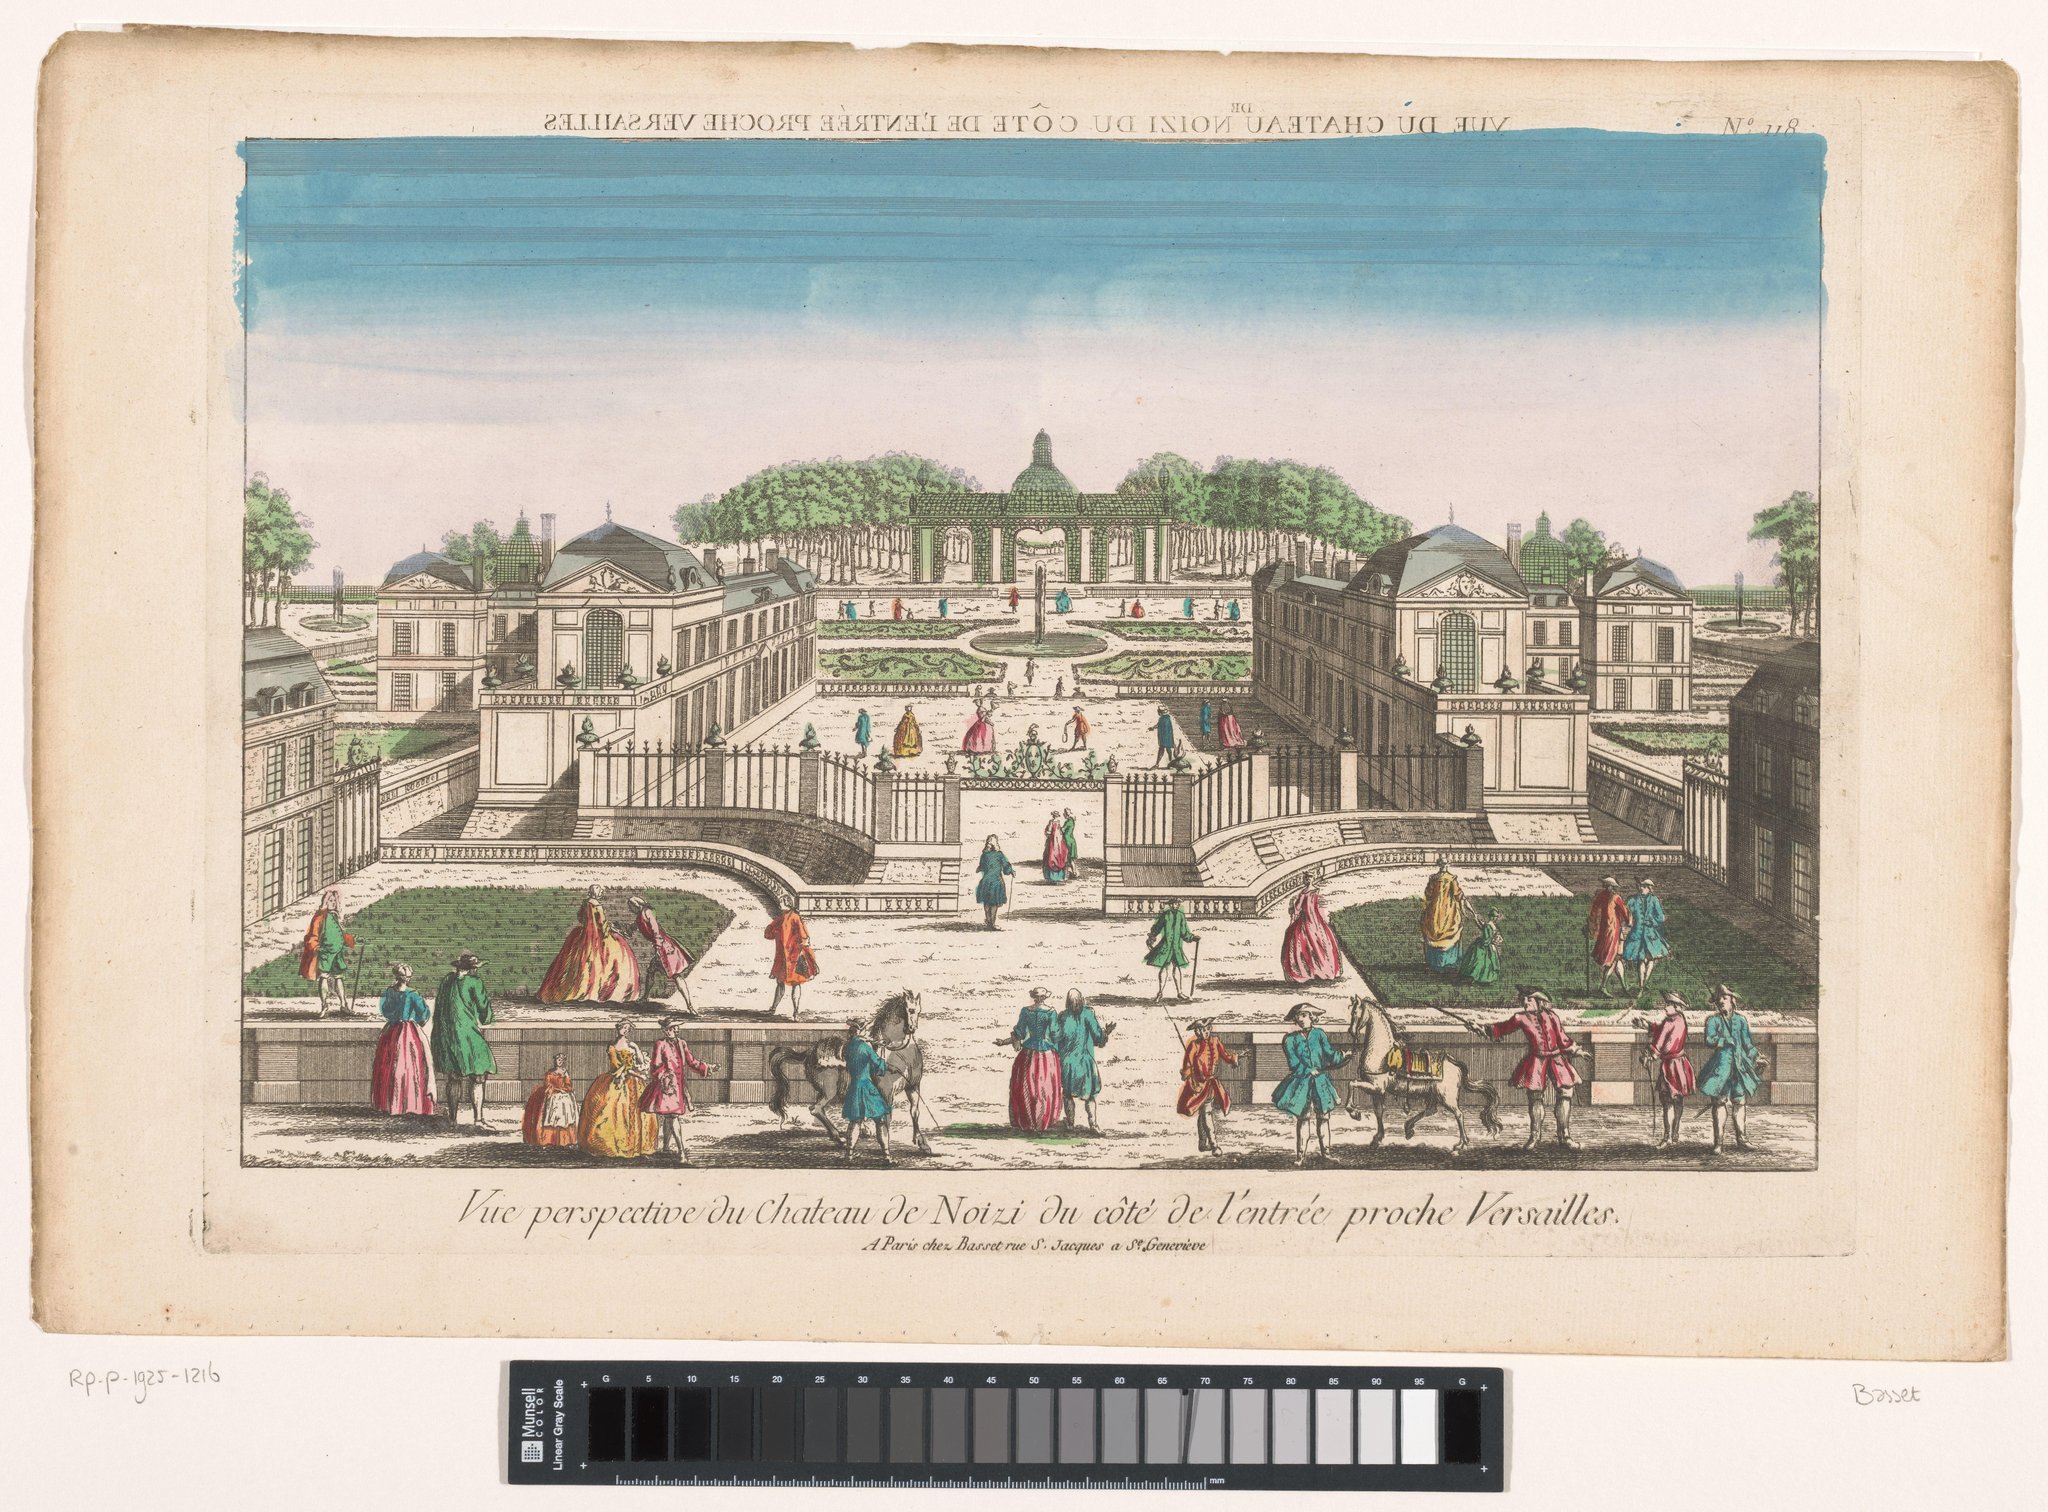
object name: print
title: Vue du chateau de Noizi du côte de l'entrée proche Versailles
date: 1700-1799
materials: paper, watercolor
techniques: brush, etching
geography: france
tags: castle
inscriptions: watermark, collector's mark: Lugt 2166